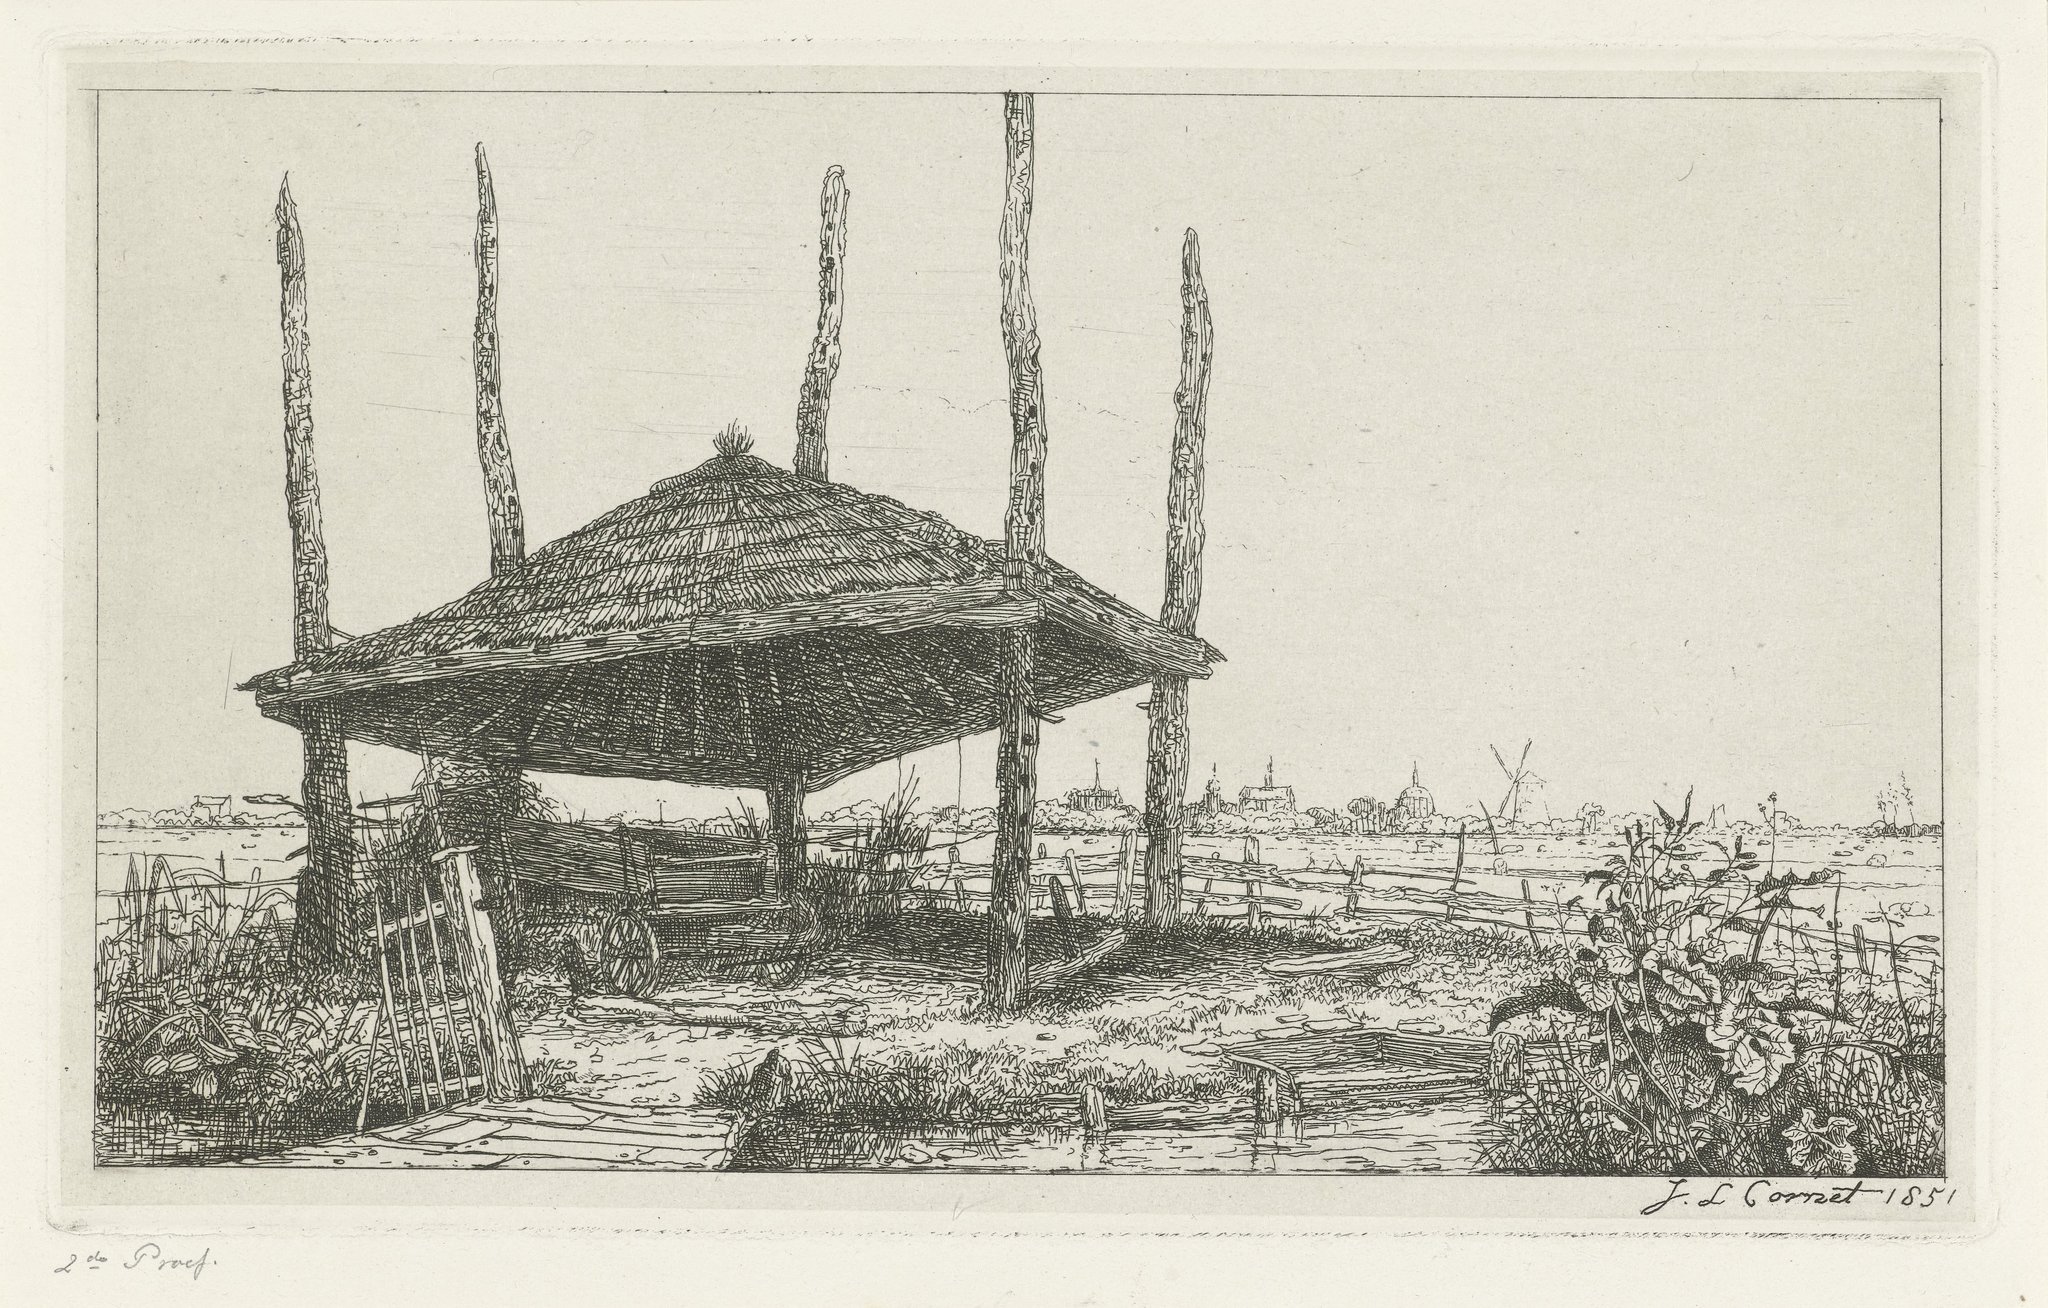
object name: print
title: Landschap met een lege hooiberg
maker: jacobus ludovicus cornet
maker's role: draughtsman, print maker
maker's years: 1815-1882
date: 1851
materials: paper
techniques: etching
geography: leiden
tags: hay-stack, prospect of city, town panorama, silhouette of city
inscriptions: collector's mark: Lugt 2166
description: Landschap met een lege hooiberg. Op de voorgrond een brug over een beekje. Op de achtergrond de contouren van een stad.